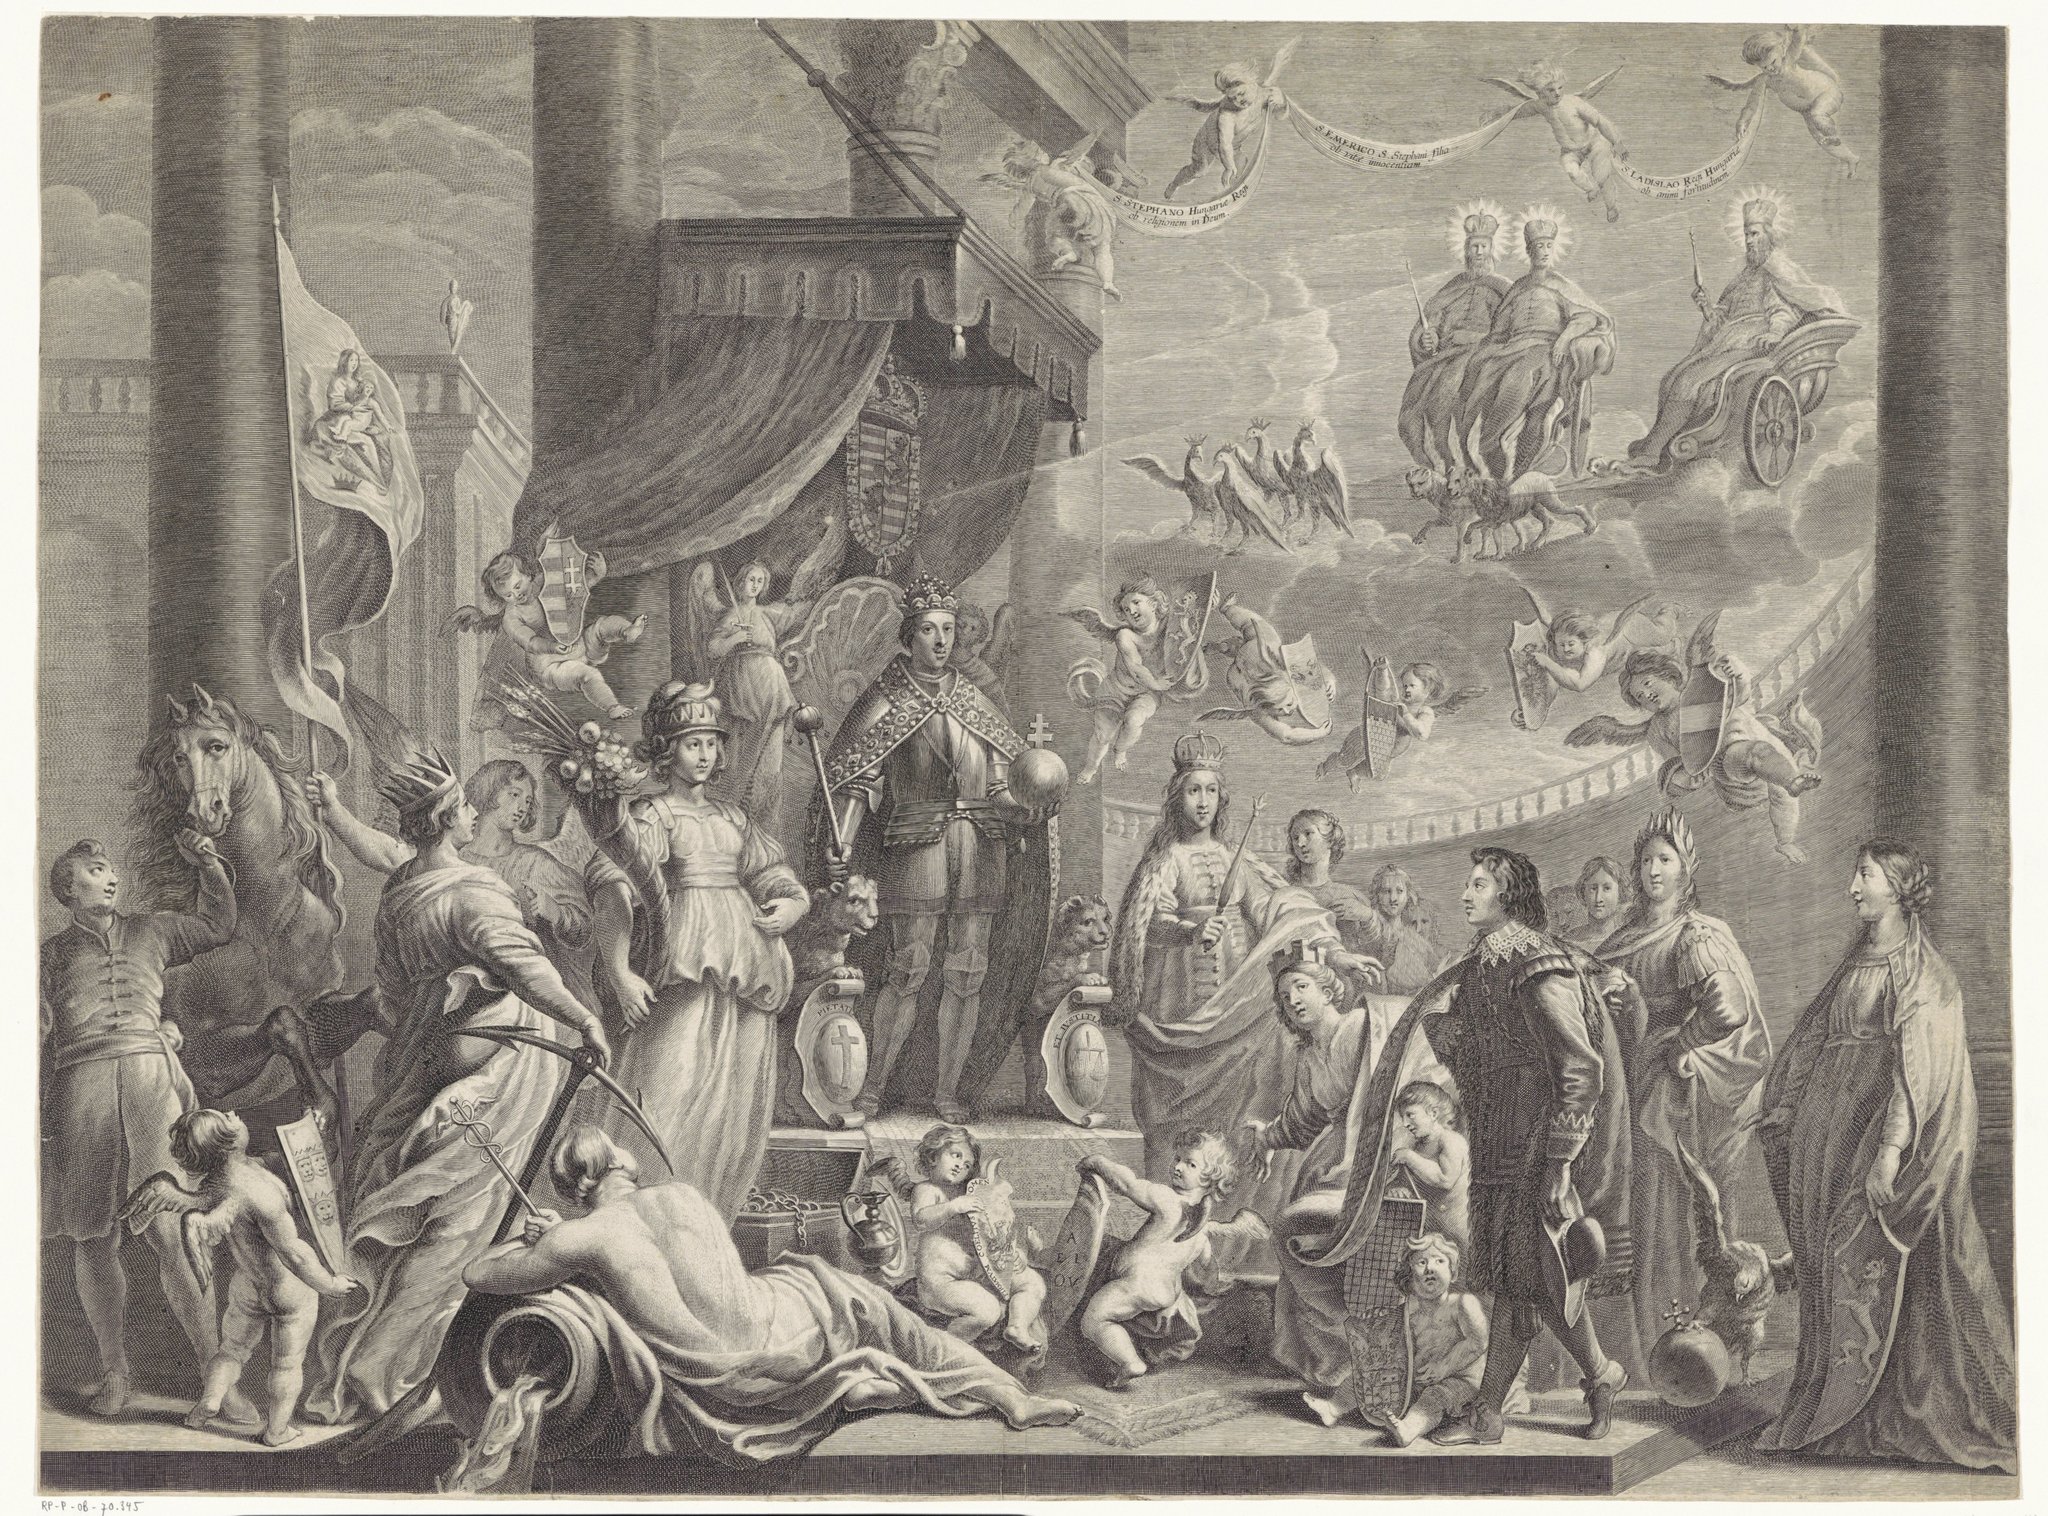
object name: print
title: Allegorische voorstelling met keizer Ferdinand III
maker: lucas vorsterman (i)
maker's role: print maker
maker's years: 1595-1675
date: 1633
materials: paper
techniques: engraving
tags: vienna, ferdinand iii (duits keizer)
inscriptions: collector's mark: Lugt 240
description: Het betreft het bovenste deel van een thesisprent van Georg Erdödy (1614-63), die in 1633 zijn thesis verdedigde aan de jezuitische universiteit van Douai.